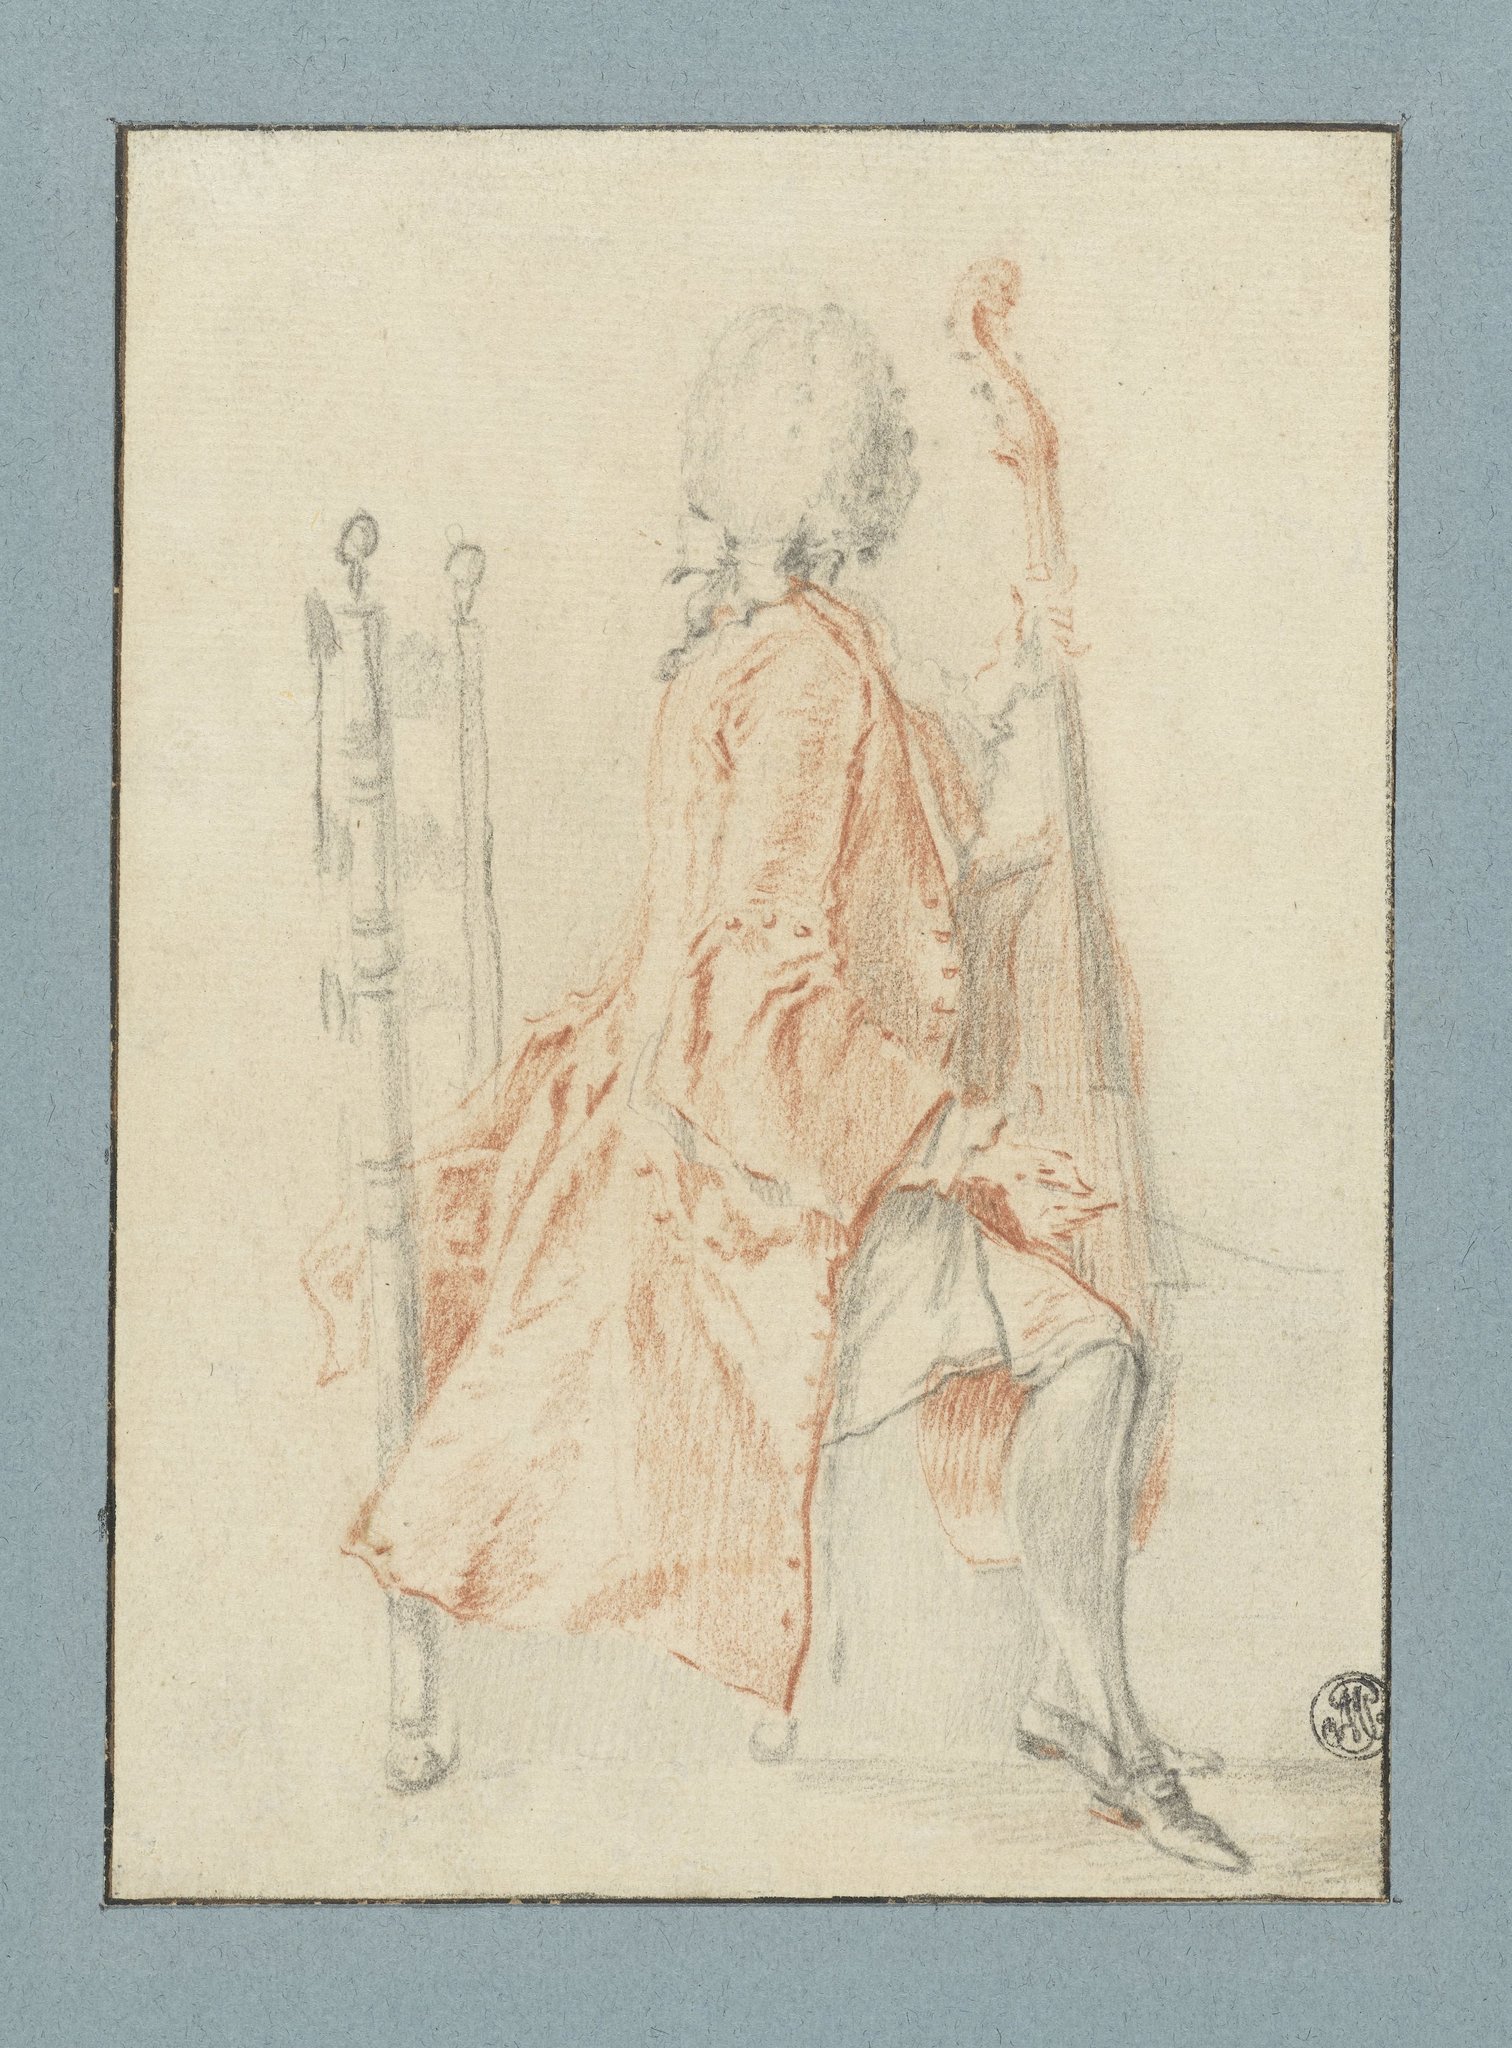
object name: drawing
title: Gambaspeler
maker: jacques andré portail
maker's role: draughtsman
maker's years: 1695-1759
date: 1740-1759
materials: chalk, graphite, paper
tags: viola, violoncello; double bass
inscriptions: collector's mark, verso, lower centre: Lugt 2228, collector's mark, recto, lower right: Lugt 1910